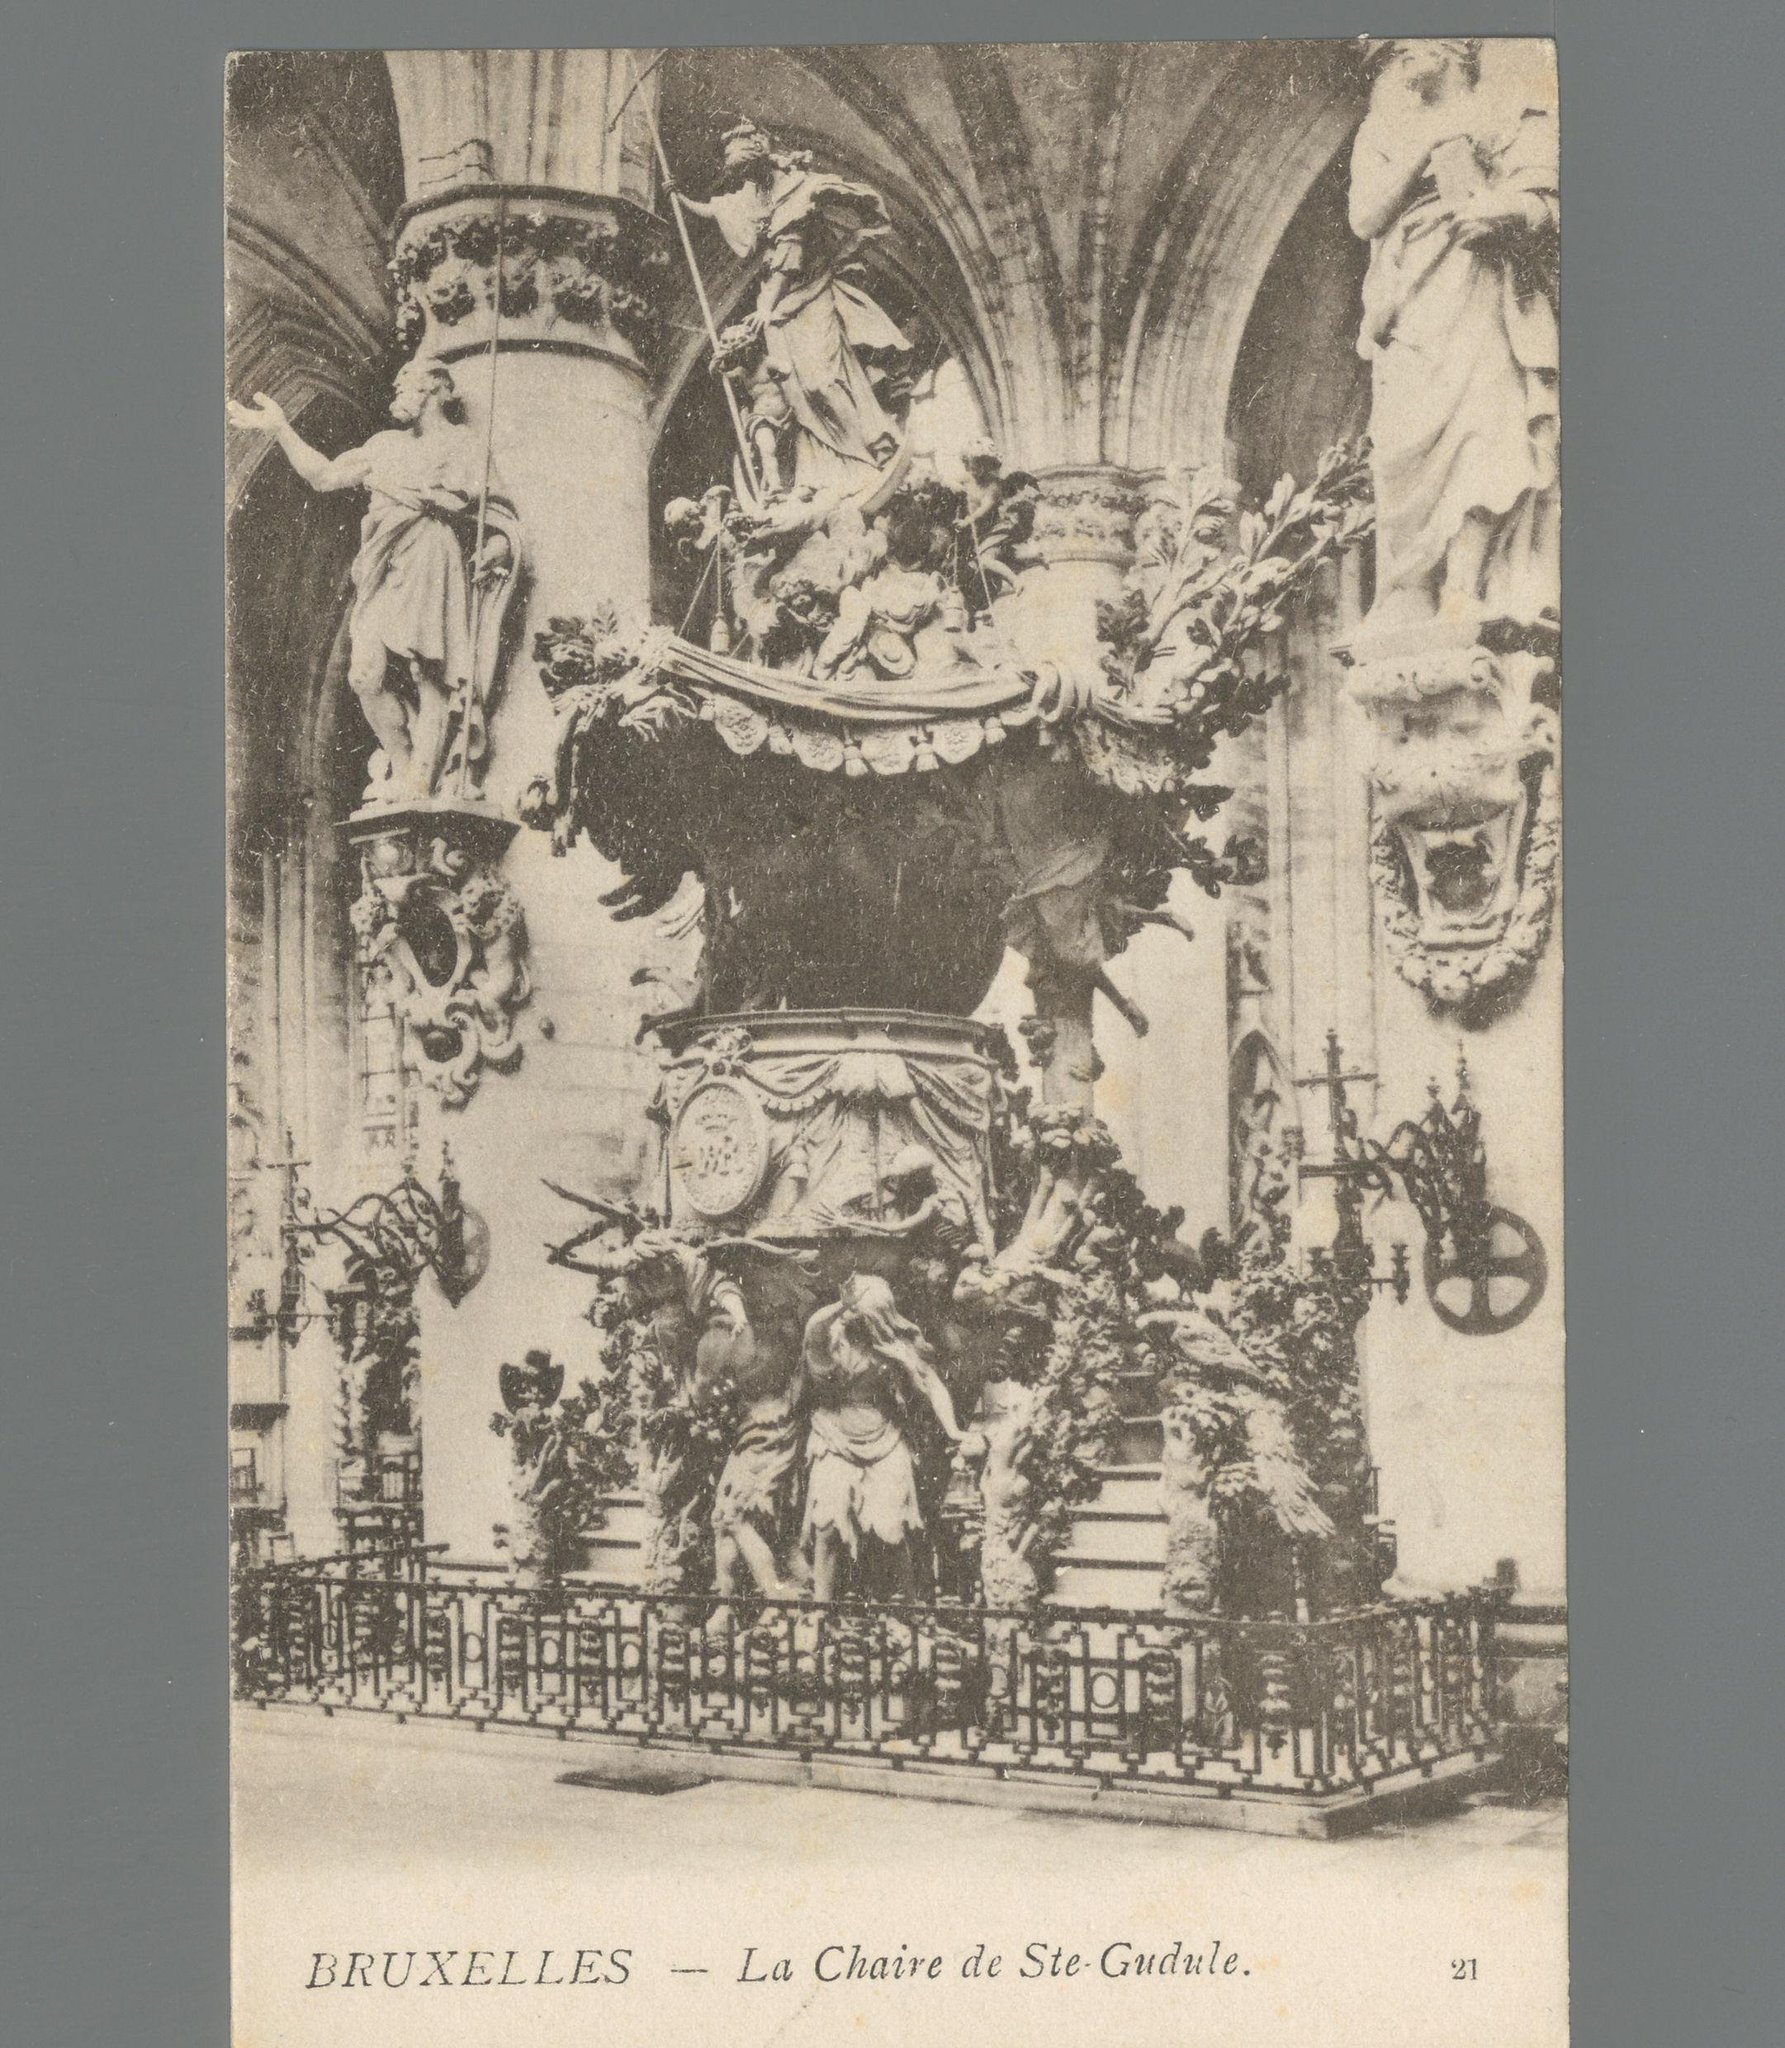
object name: ansichtkaart, prentbriefkaart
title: Bruxelles. La Chaire de Ste. Gudule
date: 1900-1906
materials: cardboard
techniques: photograph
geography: brussels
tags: interior of church, pulpit, ambo, chancel